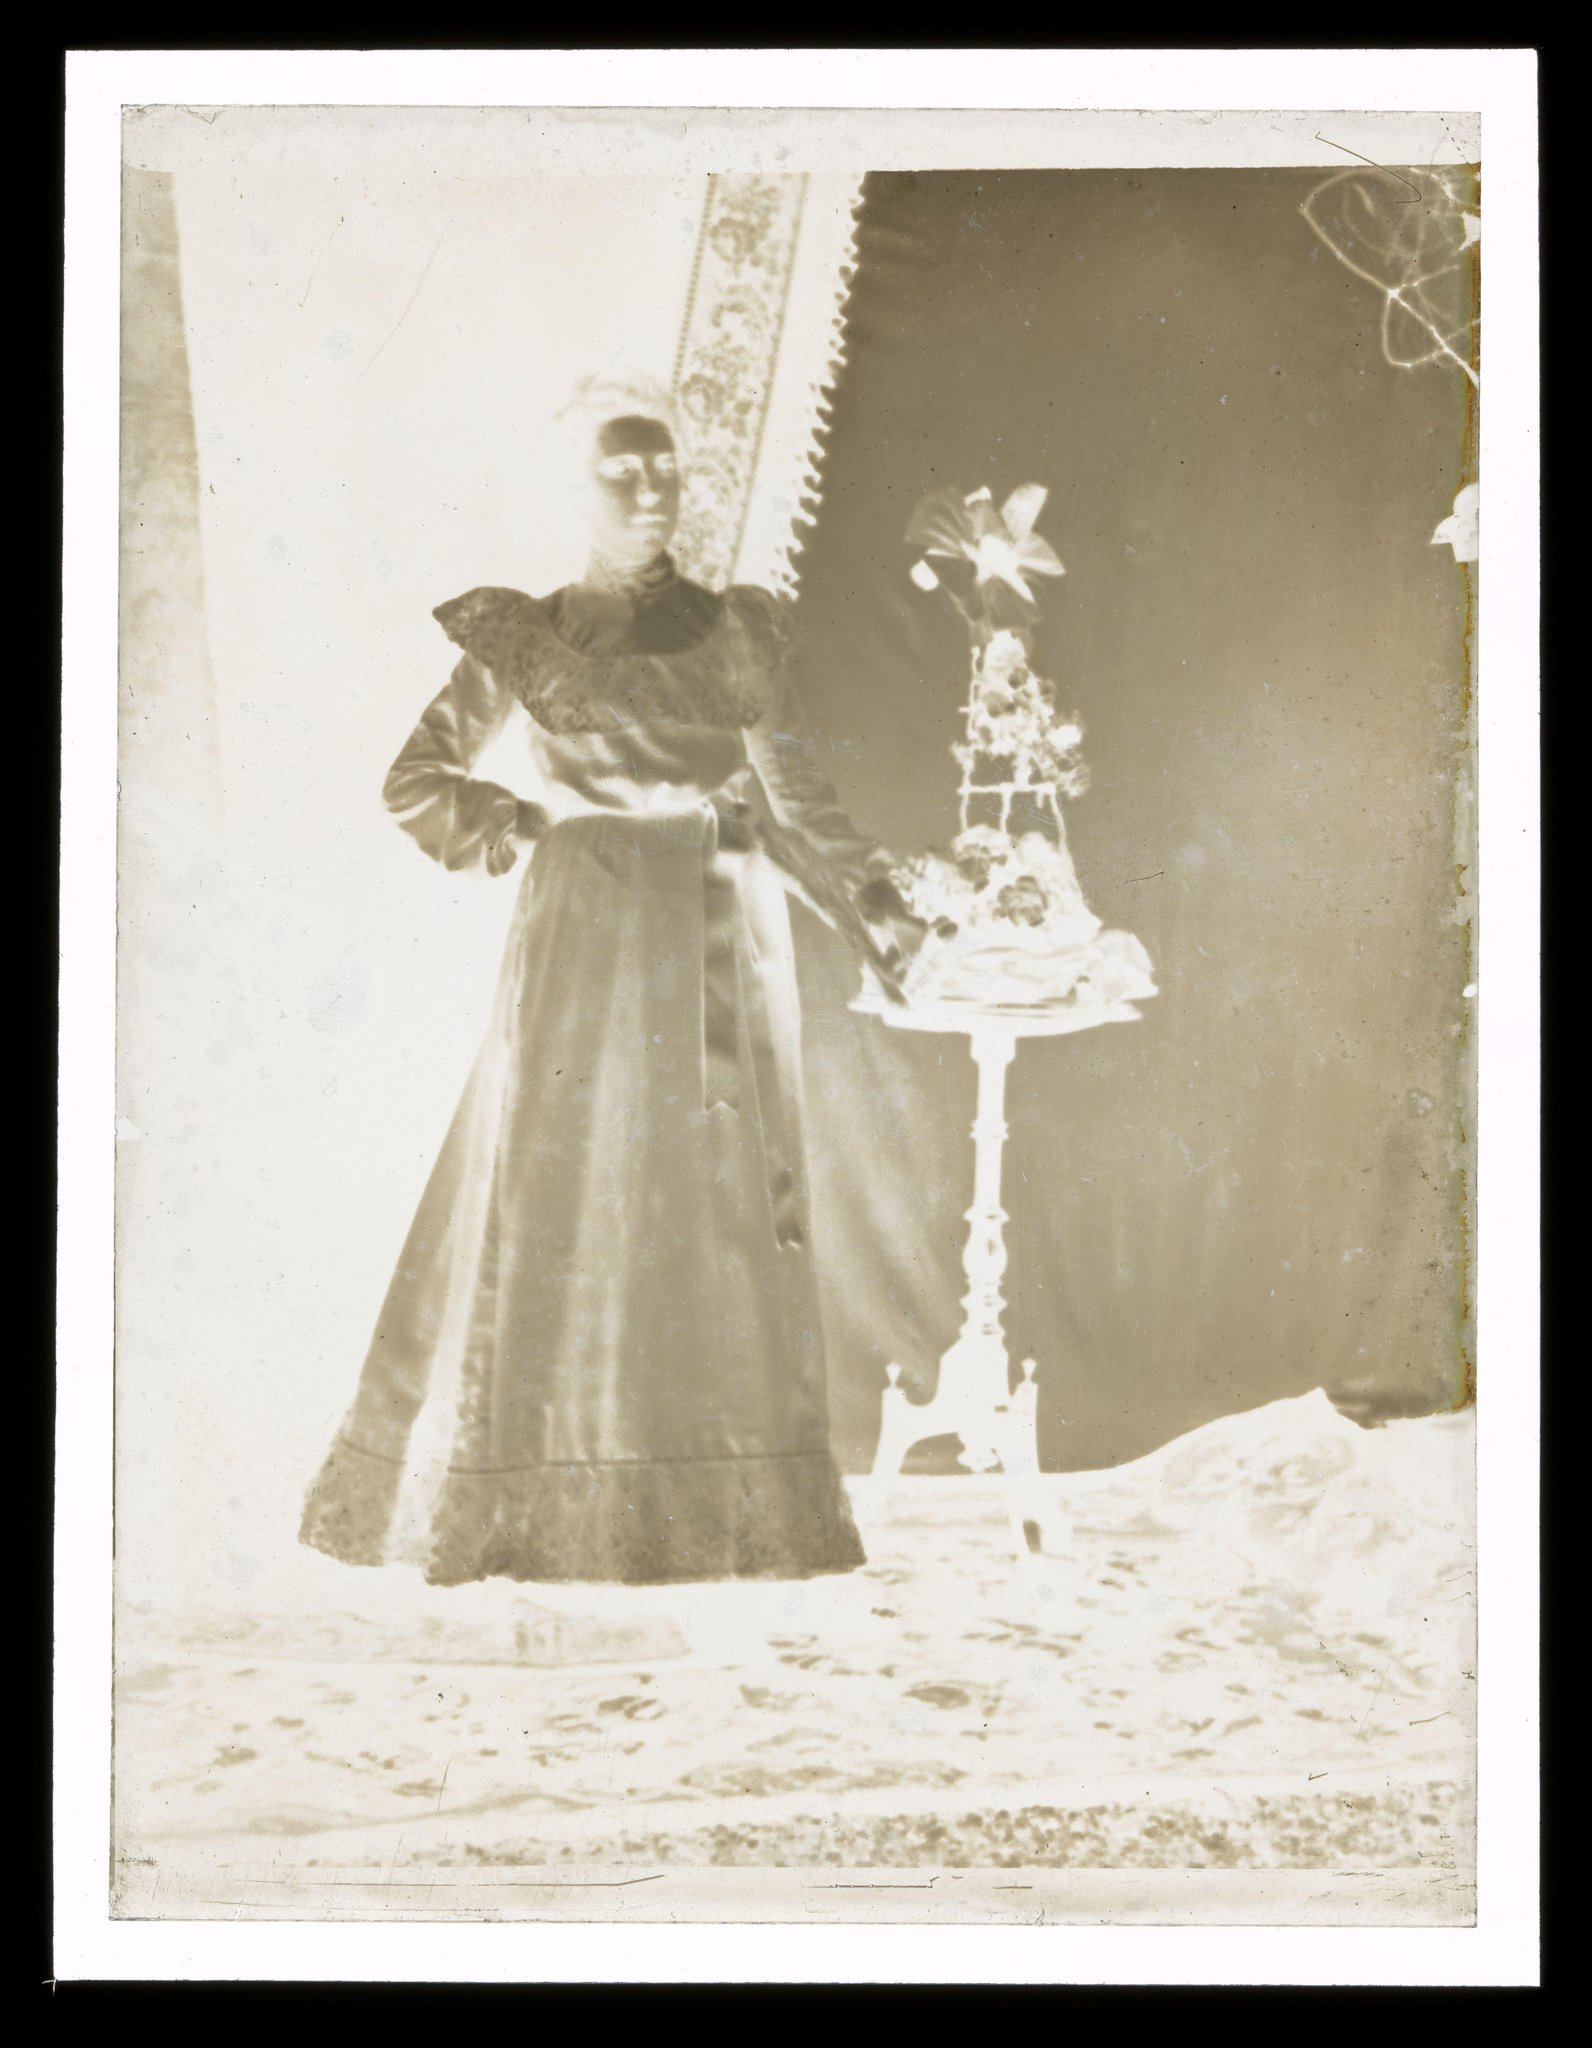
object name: photograph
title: Portret van een onbekende vrouw naast een bijzettafel met bloemstuk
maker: Anonymous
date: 1907-1935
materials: glass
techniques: gelatin glass negative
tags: cut flowers; nosegay, bunch of flowers, historical persons not known by name - bb - woman